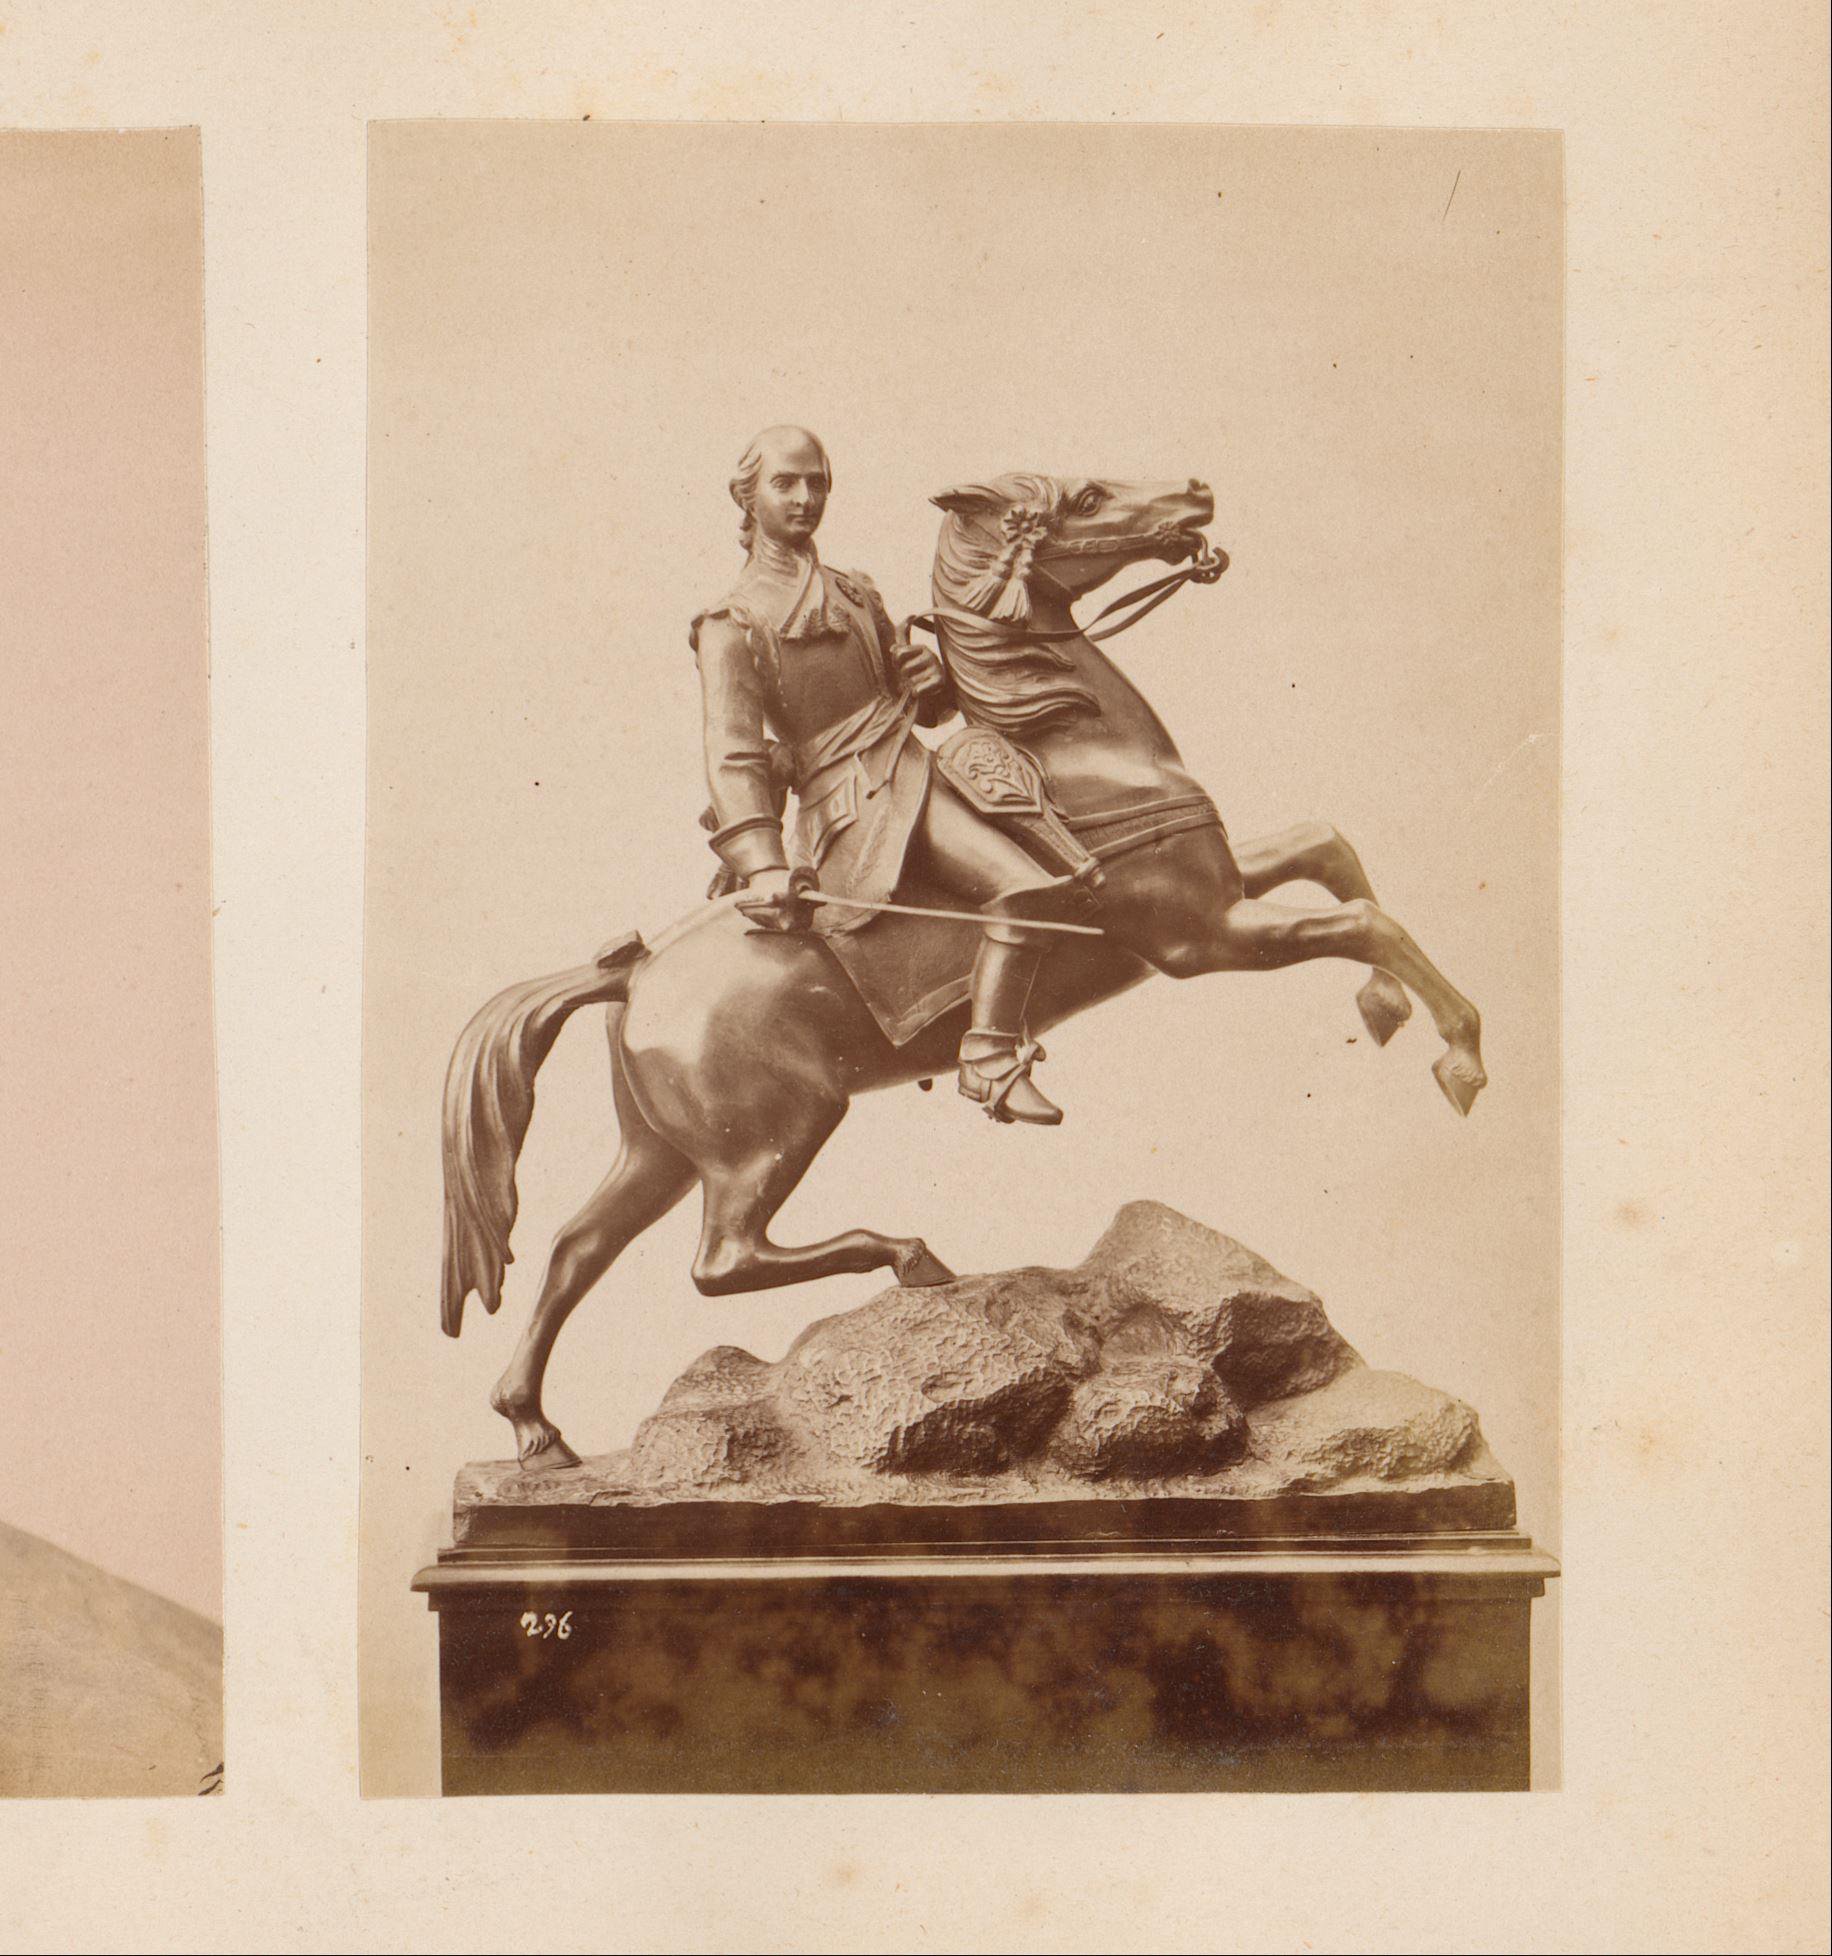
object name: page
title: Metalen sculptuur van een ruiter te paard, lid familie Persico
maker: Anonymous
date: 1860-1885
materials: photographic support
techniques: albumen print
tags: riding a horse, ass, or mule; rider, horseman, sculpture